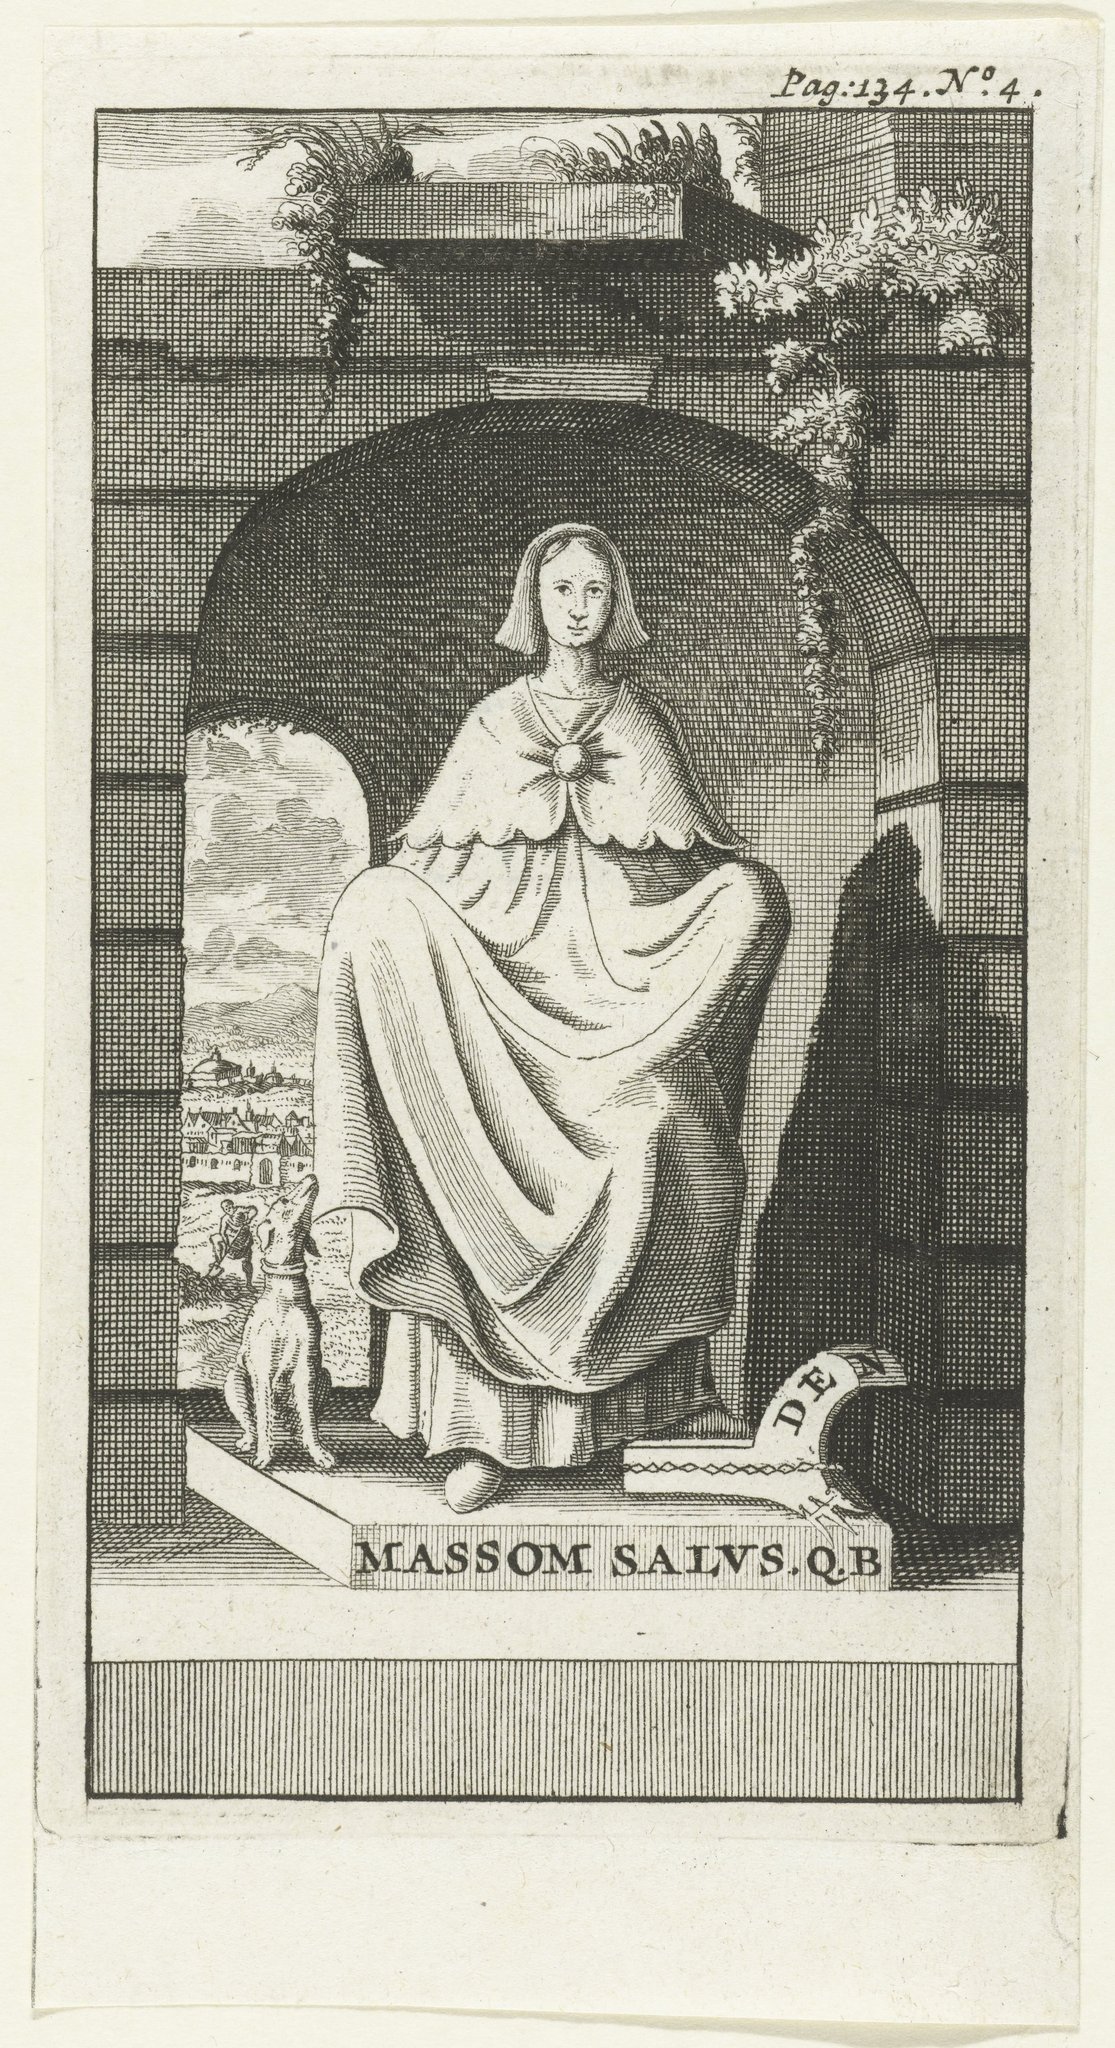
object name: print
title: Altaar met beeldje van een vrouw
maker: Anonymous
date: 1713-1717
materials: paper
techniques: etching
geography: netherlands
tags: altar ~ roman religion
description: Illustratie voor: Mattheus Gargon, Walchersche arkadia, Samuel (I) Luchtmans, Leiden 1715-1717, pag. 134 No. 4.